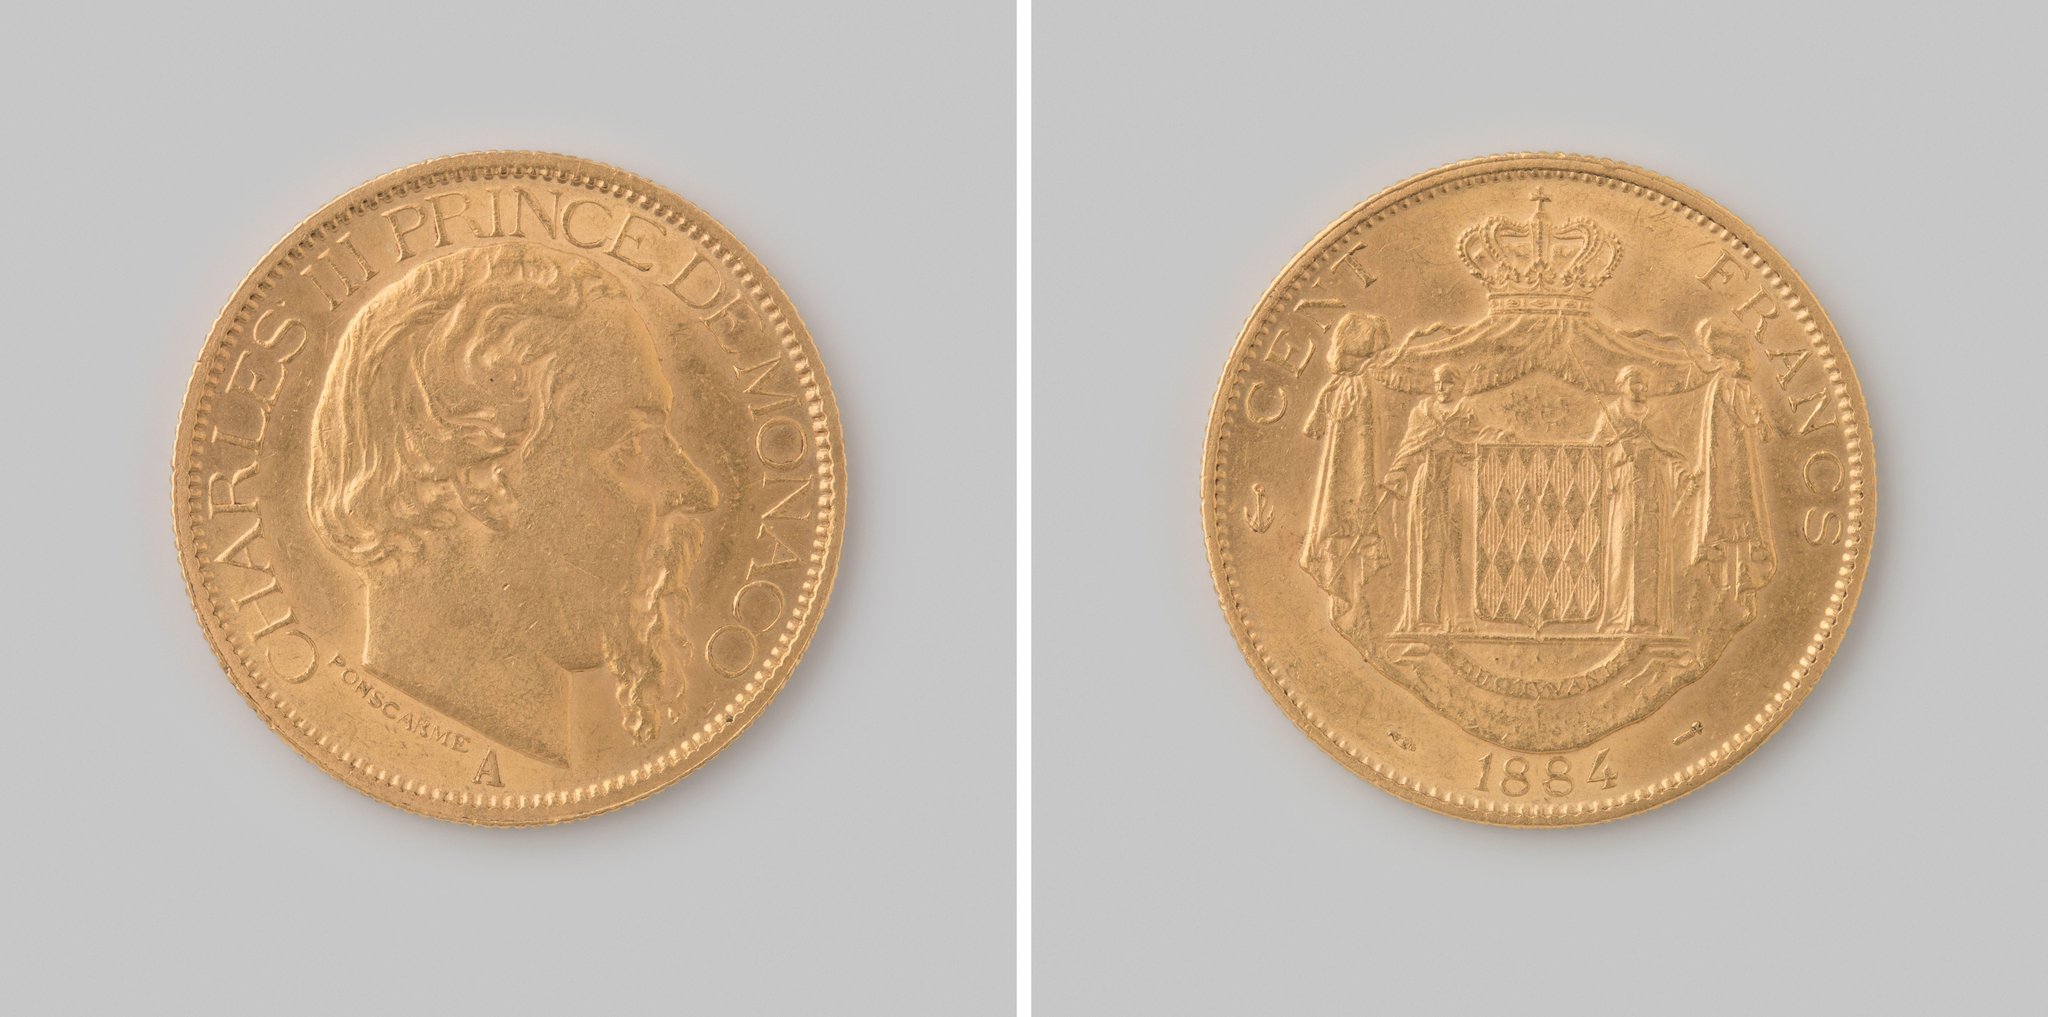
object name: coin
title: 100 francs uit Monaco van Charles III, 1884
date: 1884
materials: gold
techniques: striking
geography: paris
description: Gouden munt. Voorzijde: hoofd van de prins naar rechts. Daaronder letter A [=Parijs]. Keerzijde: op gekroonde mantel door twee schildhouders gehouden wapenschild, waaronder wapenspreuk. Waarde-aanduiding als omschrift. jaartal onderaan.Kartelrand.